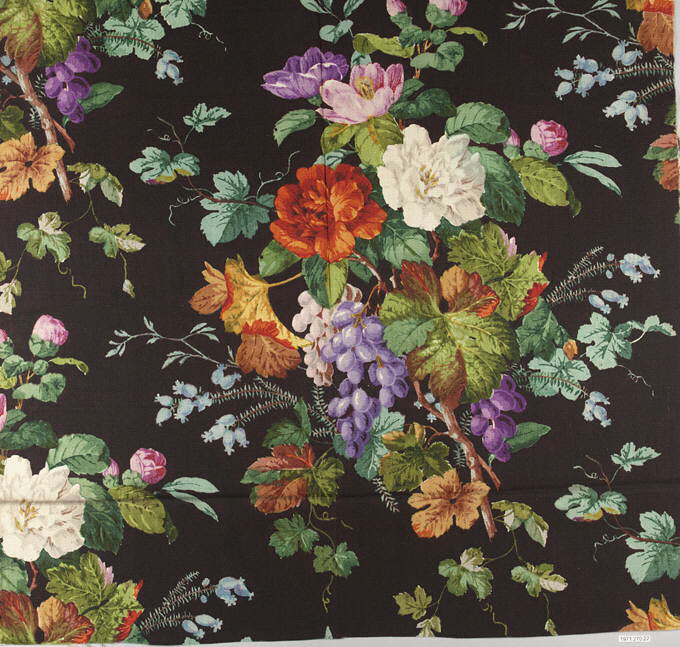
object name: piece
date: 1856-1875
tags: flowers,leaves